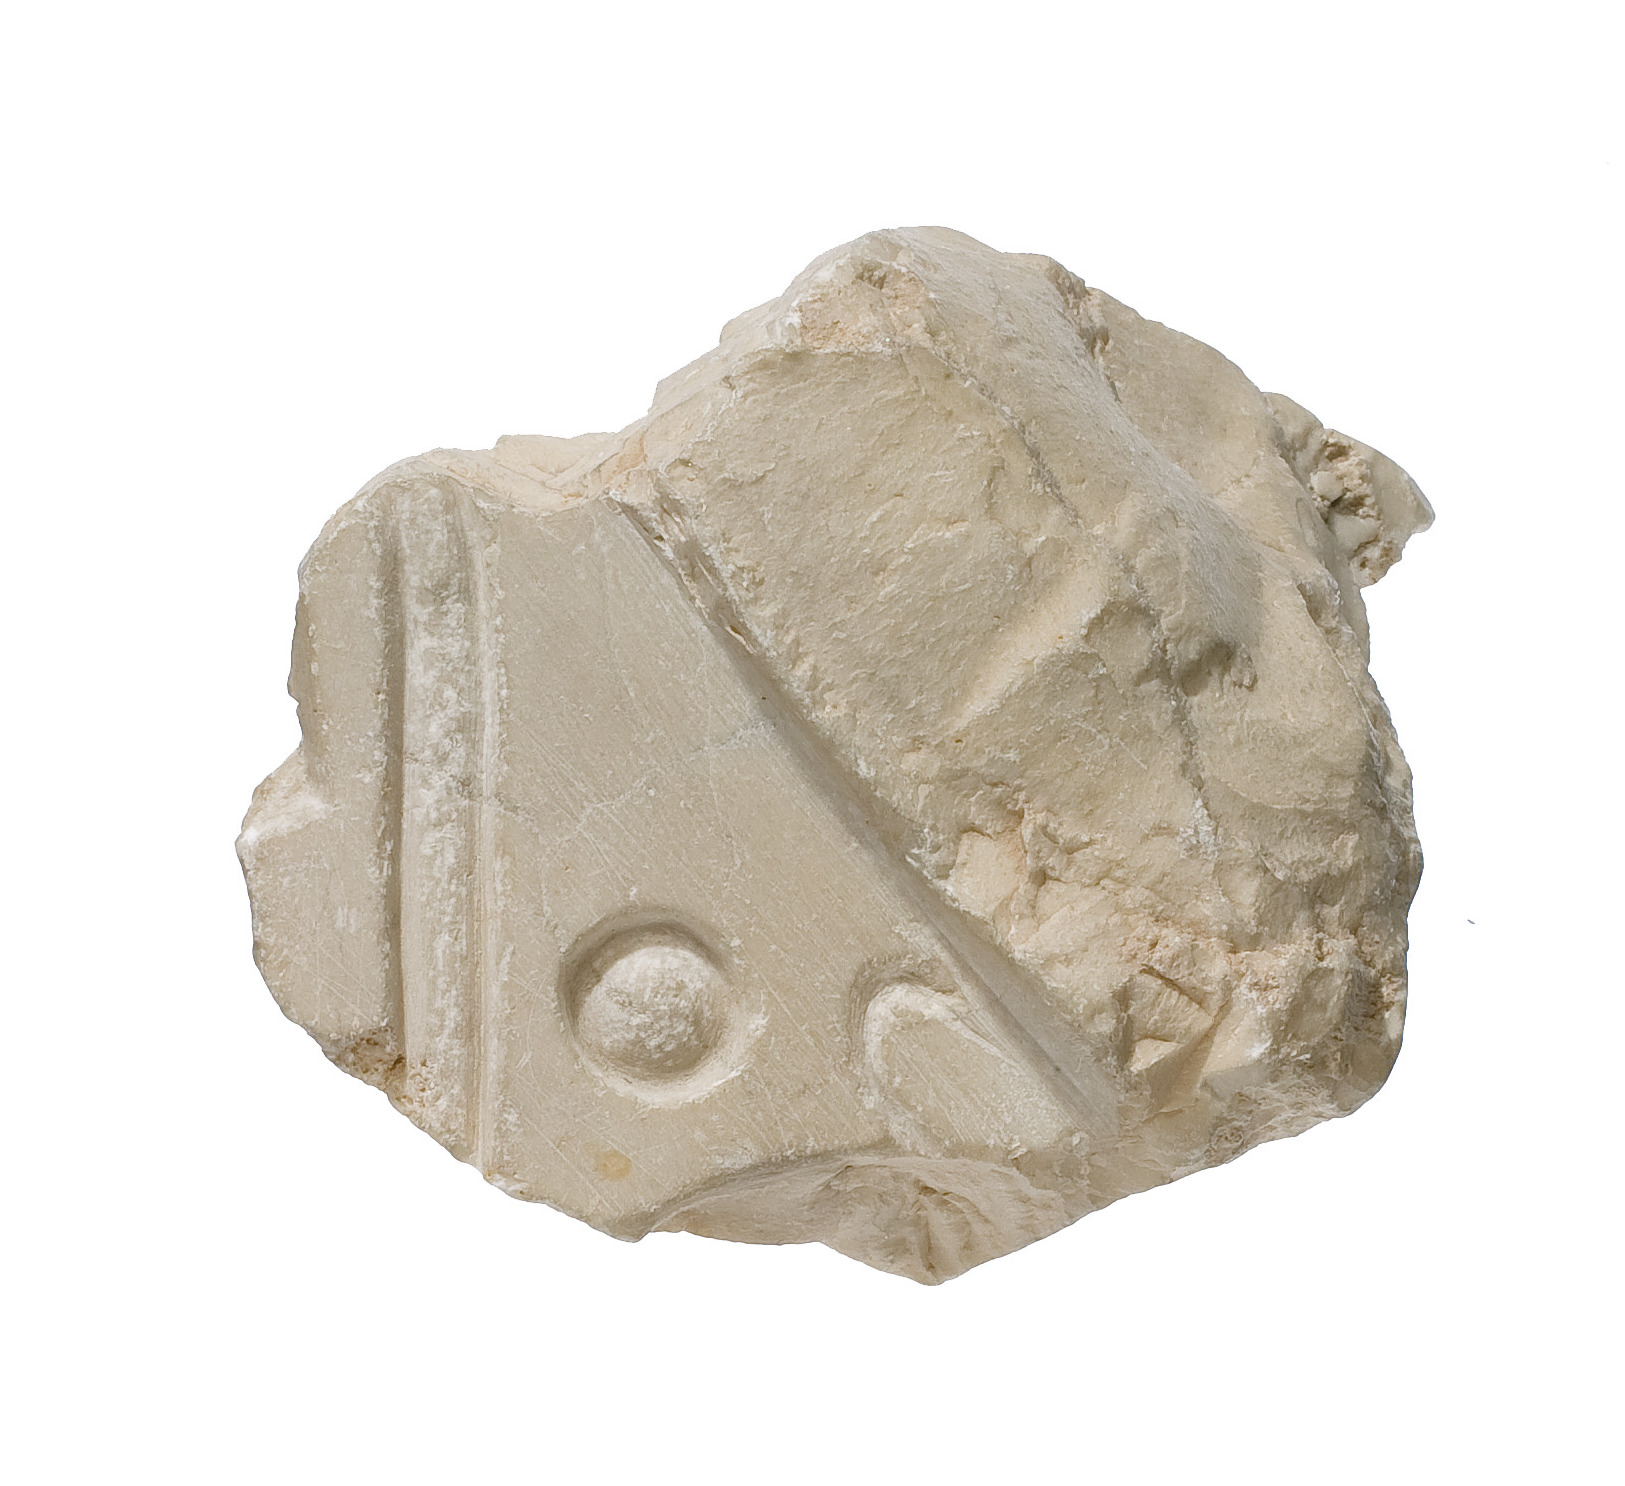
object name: head of akhenaten, blue crown, back pillar, inscribed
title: Inscribed side of back pillar from head of Akhenaten in blue crown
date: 1353-1336 BCE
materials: limestone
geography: egypt